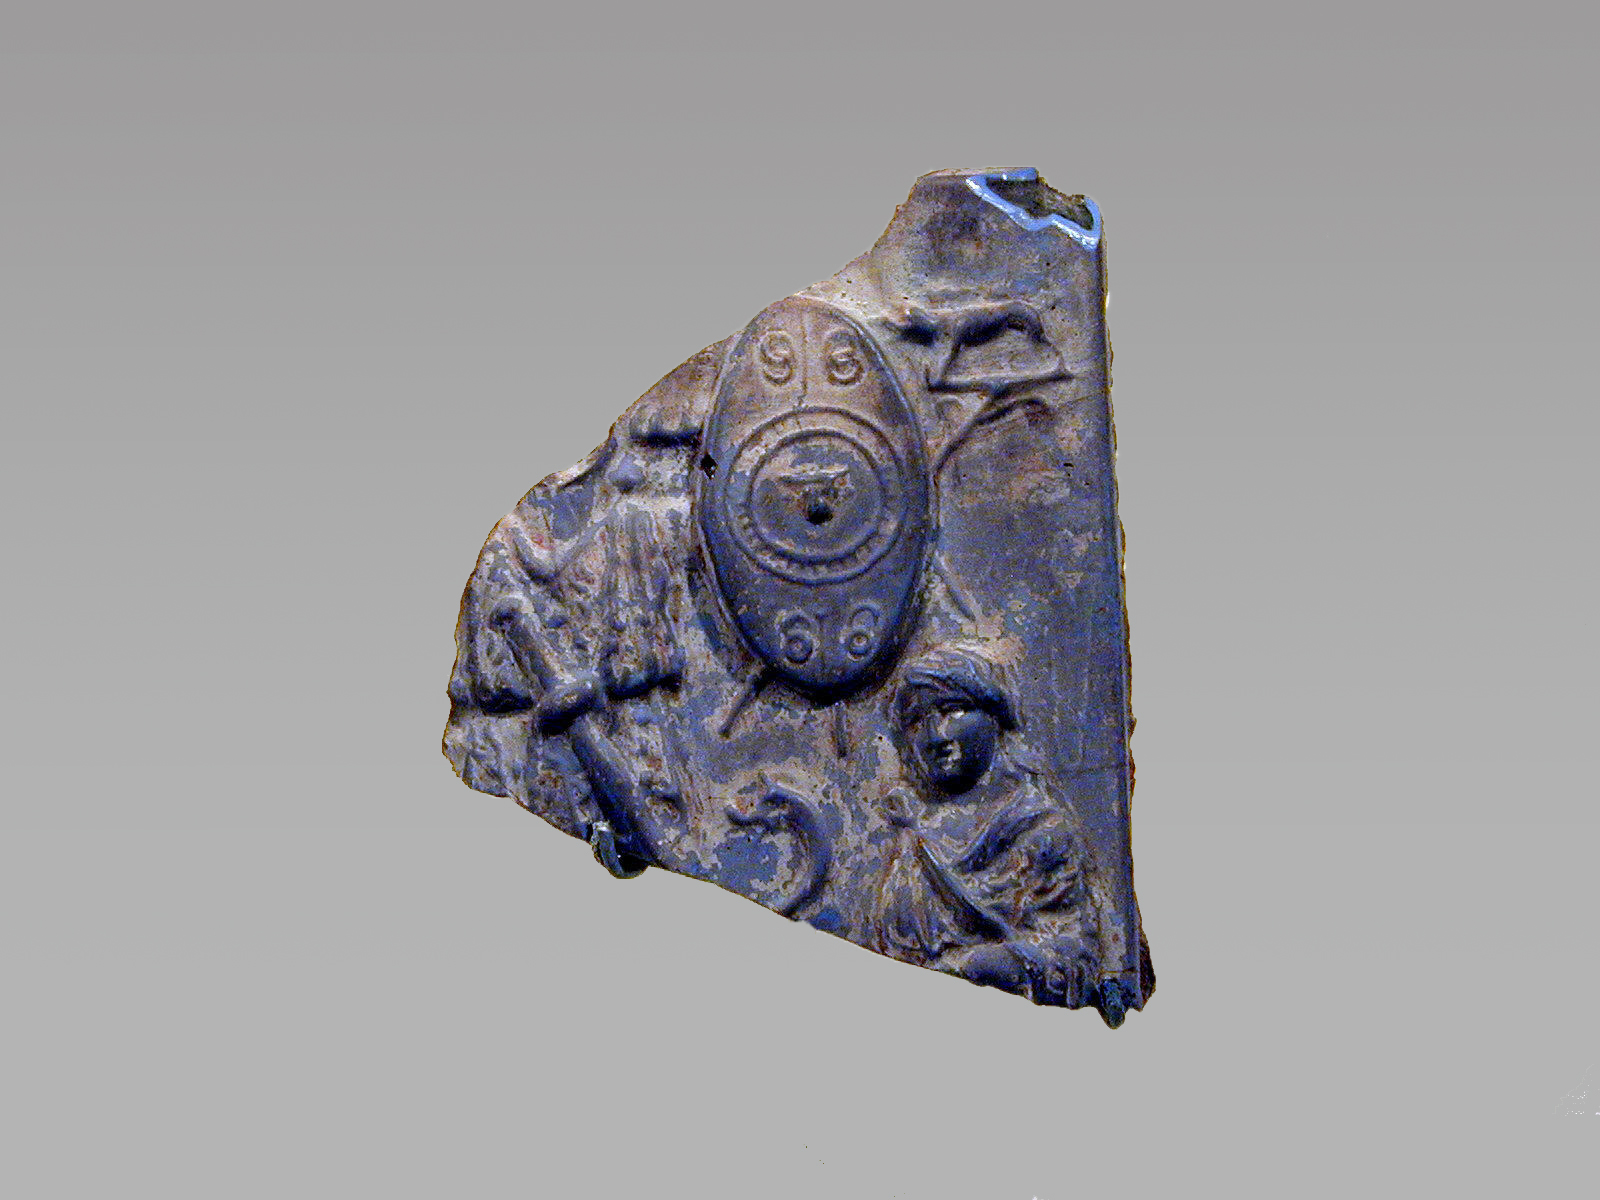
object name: relief fragment with weapon and captive woman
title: Glass plaque fragment depicting a trophy and captives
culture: roman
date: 1-100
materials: glass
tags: trophies